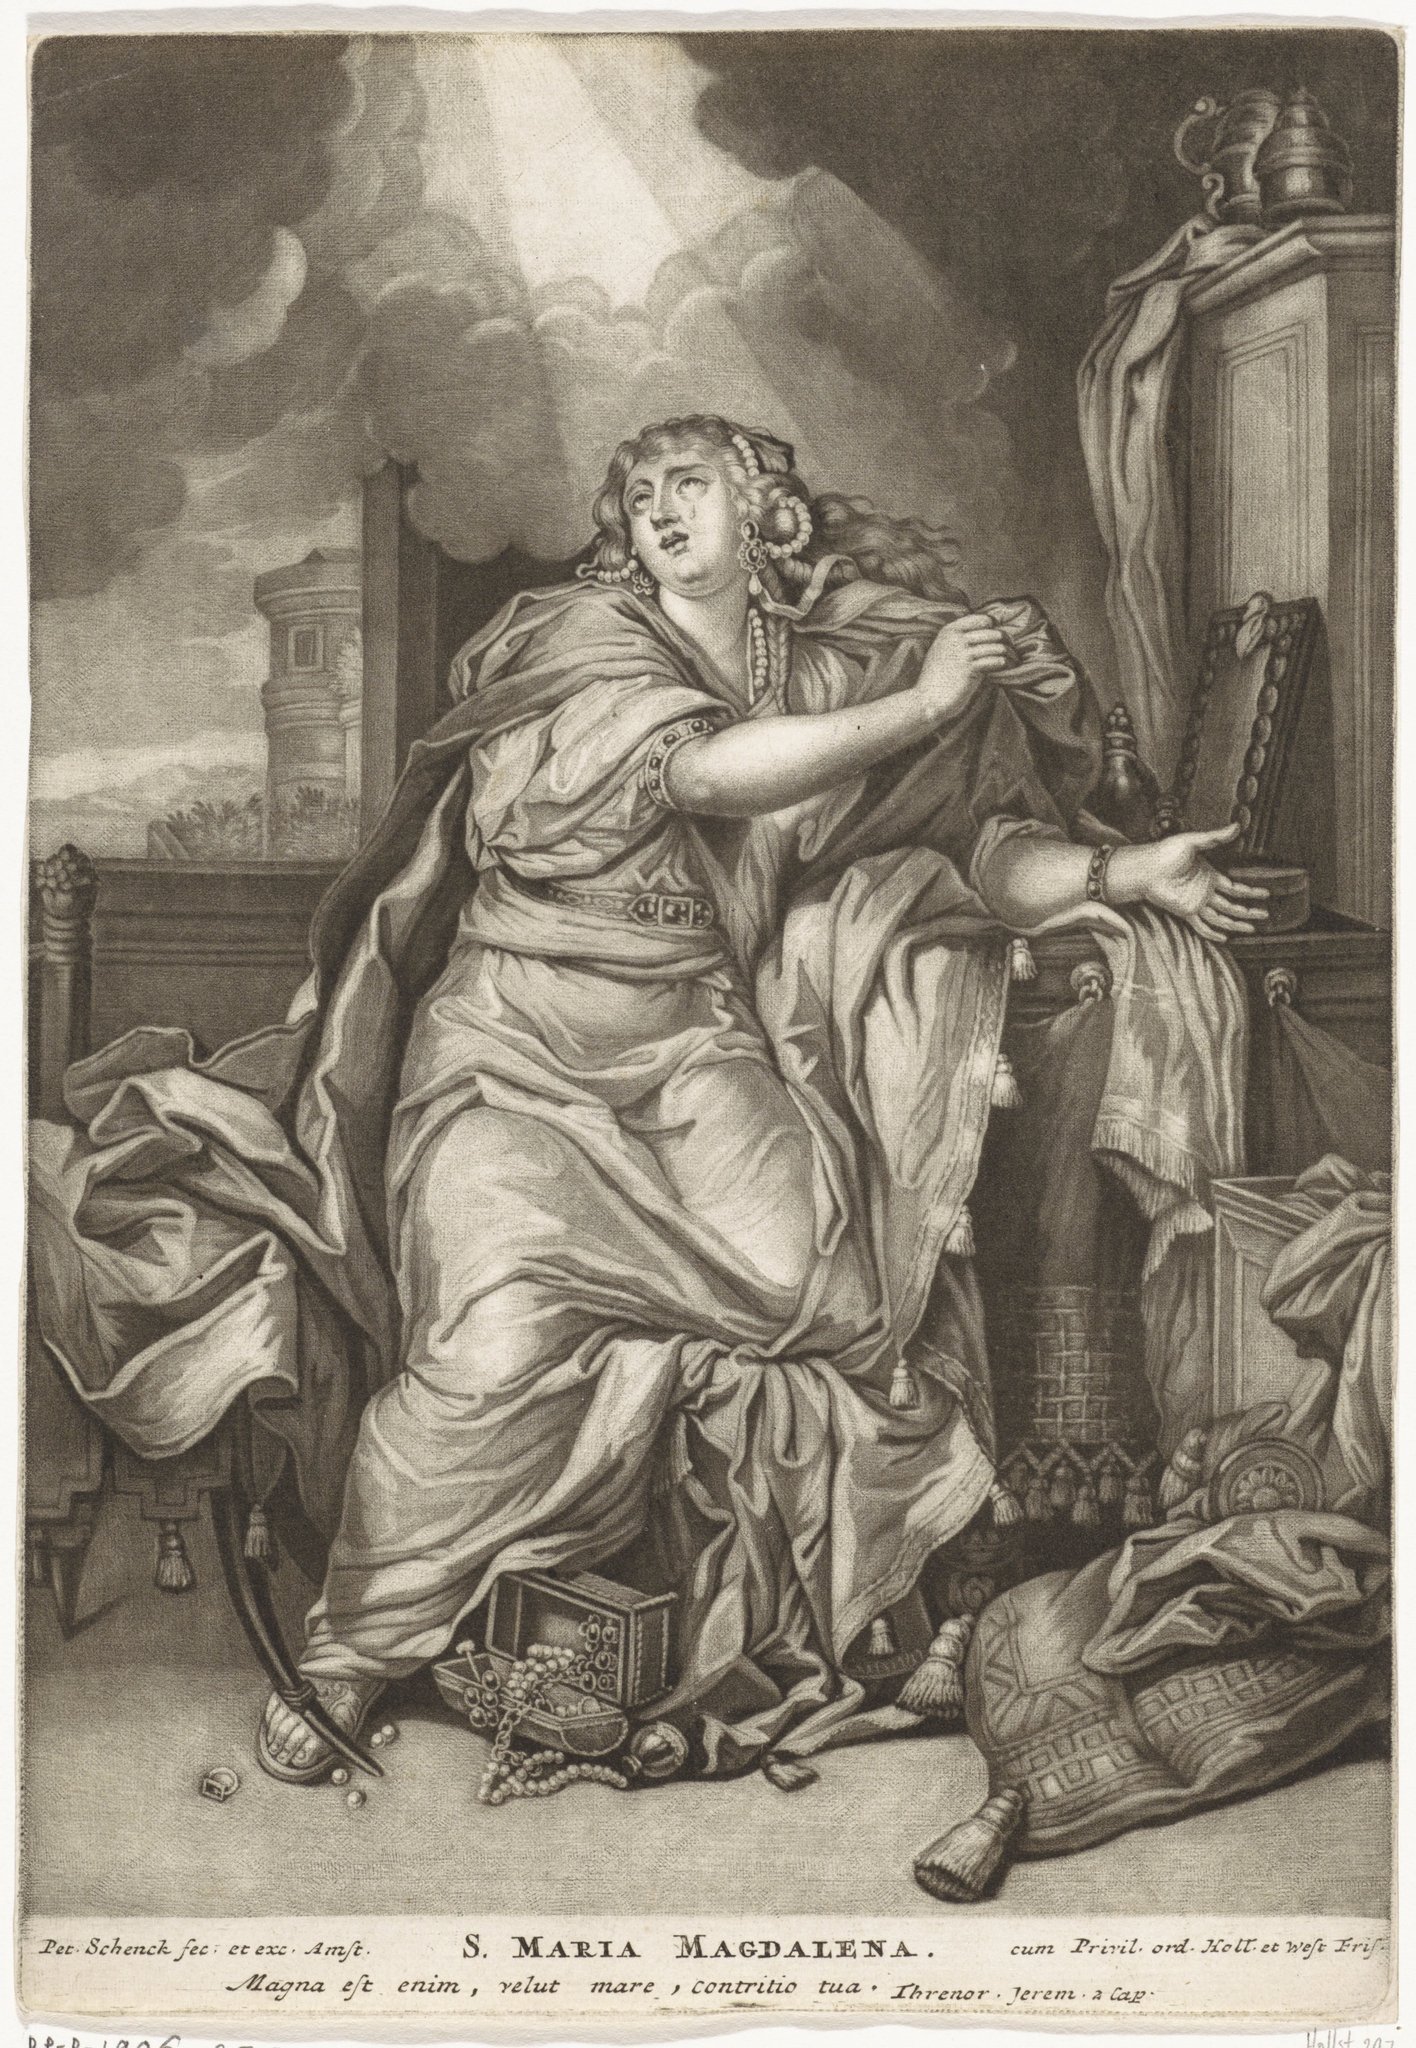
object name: print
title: H. Maria Magdalena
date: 1670-1713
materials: paper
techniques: engraving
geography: amsterdam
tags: the penitent harlot mary magdalene; possible attributes: book (or scroll), crown, crown of thorns, crucifix, jar of ointment, mirror, musical instrument, palm-branch, rosary, scourge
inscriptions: collector's mark: Lugt 2228